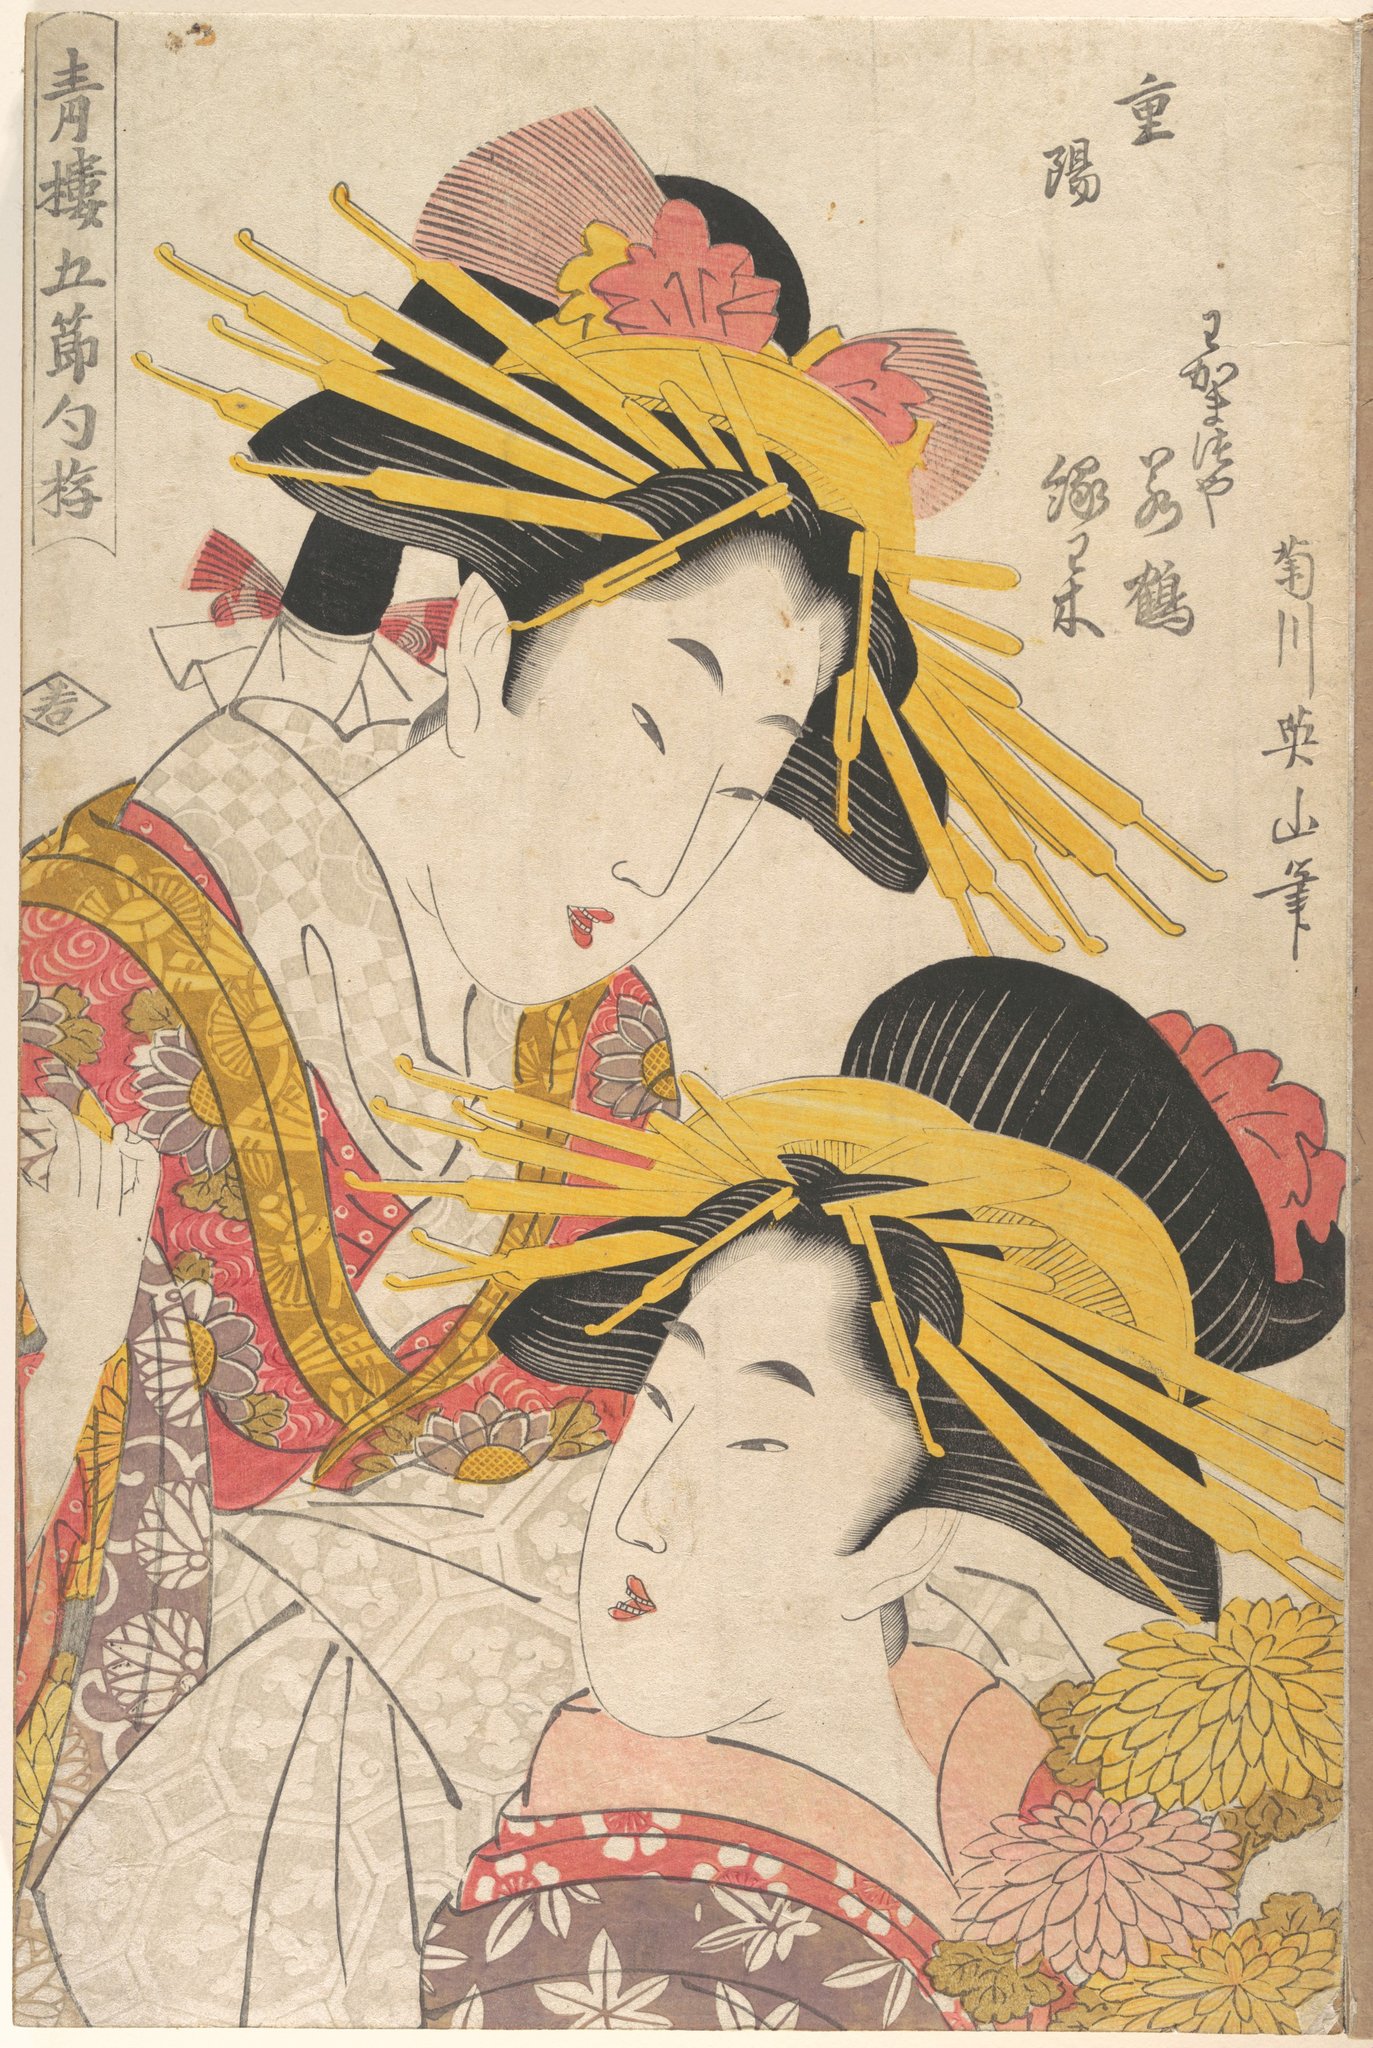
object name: print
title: Album of Prints by Kikugawa Eizan, Utagawa Kunisada, and Utagawa Kunimaru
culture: japanese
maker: kikugawa eizan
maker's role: artist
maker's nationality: japanese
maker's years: 1787-1867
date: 1801-1900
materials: ink, paper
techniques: woodblock print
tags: women